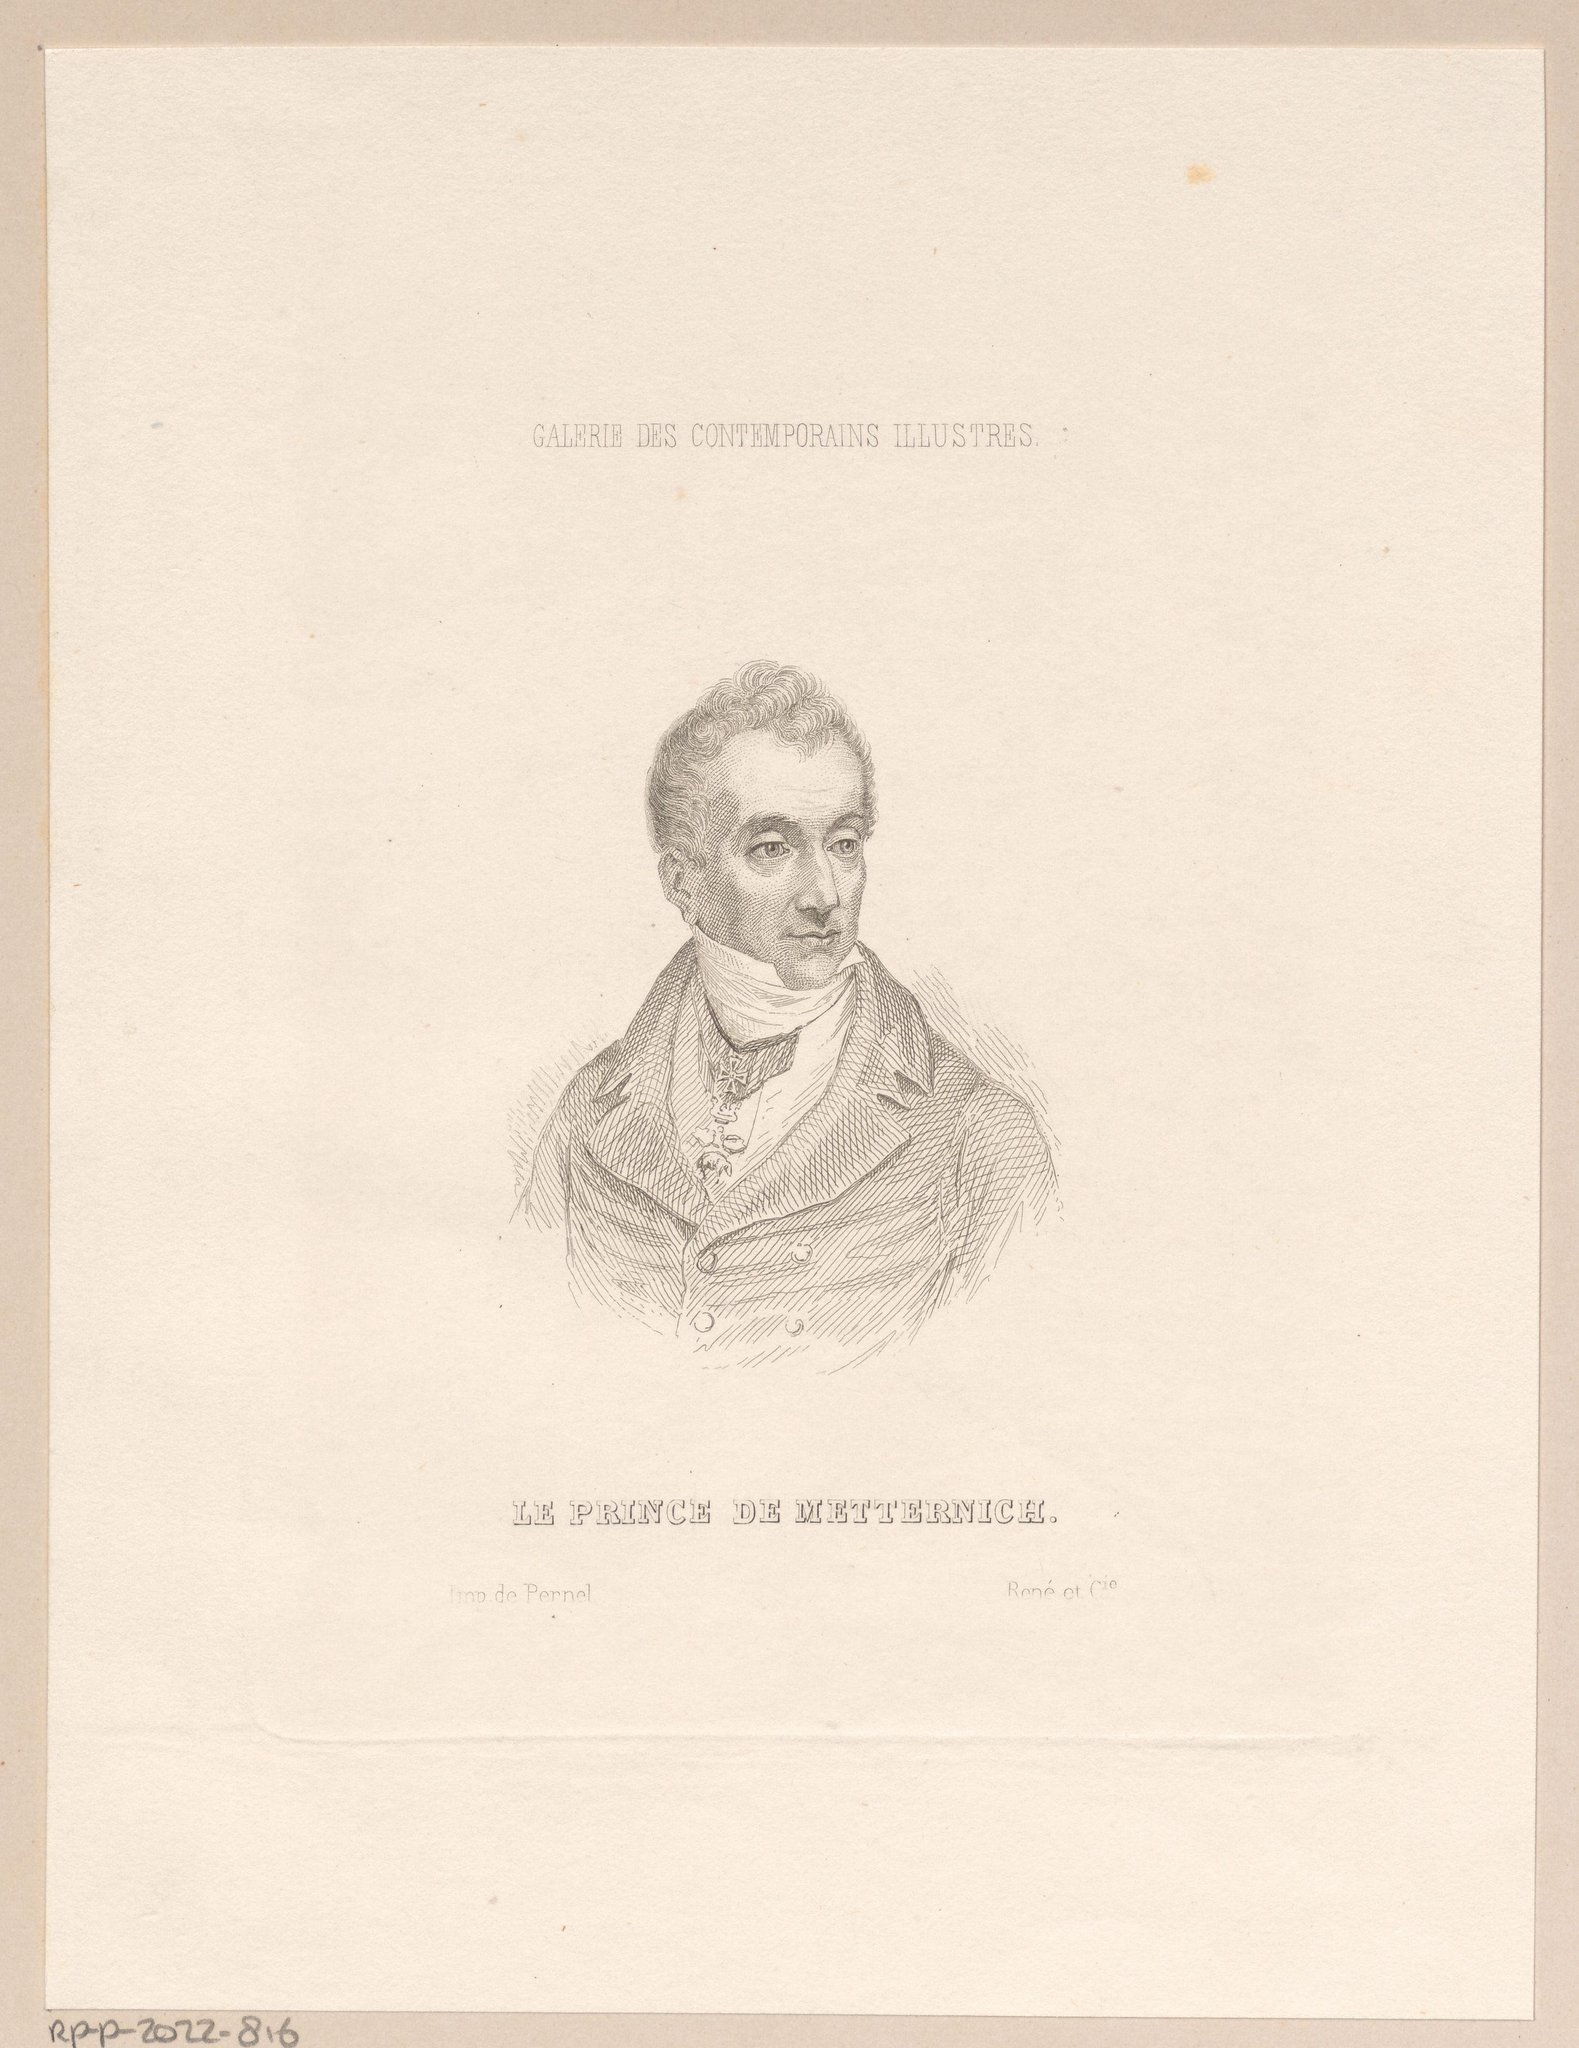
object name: print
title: Galerie des contemporains illustres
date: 1840-1850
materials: paper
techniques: etching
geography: paris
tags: vienna, historical persons, politician, e.g. party leader, ruler, sovereign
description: Prent waarschijnlijk uit een uitgave van Galerie des Contemporains Illustres.